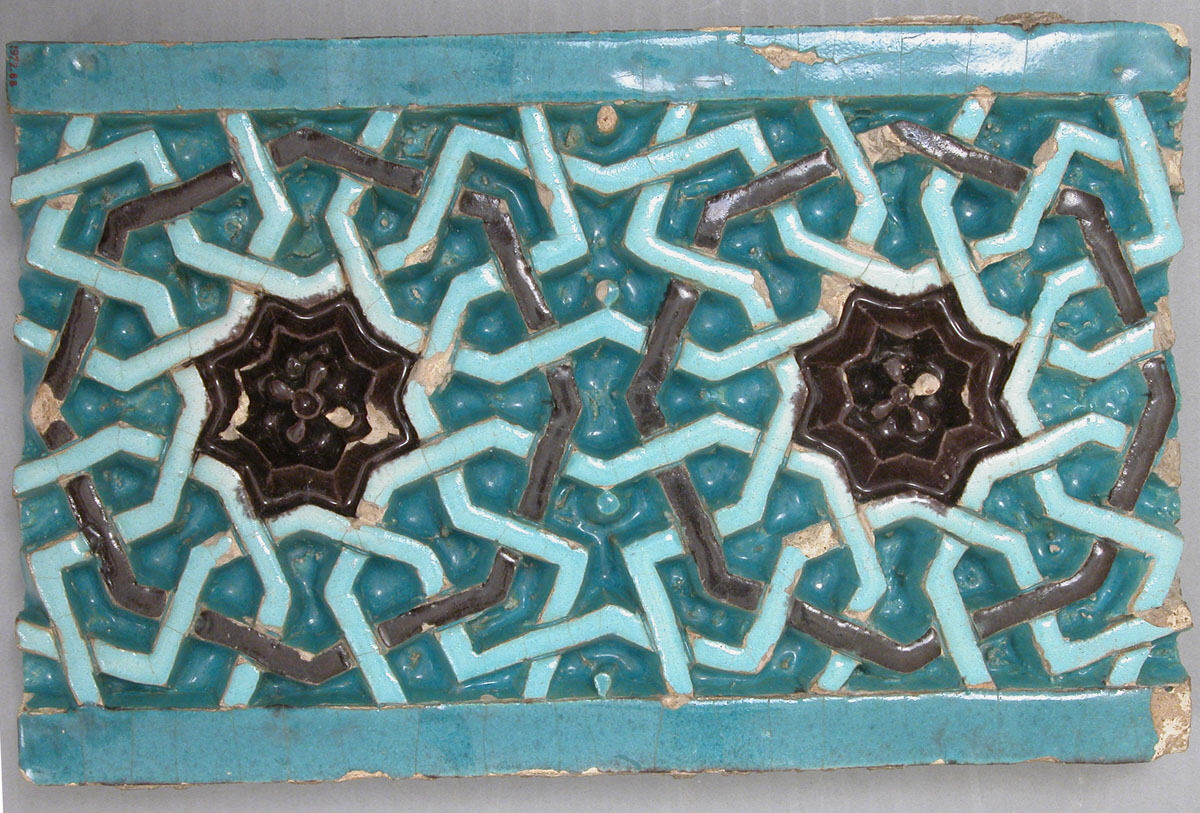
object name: tile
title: Tile Decorated with Entrelacs Pattern Based on Octagons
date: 1351-1400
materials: stonepaste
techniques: carving, glazing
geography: uzbekistan